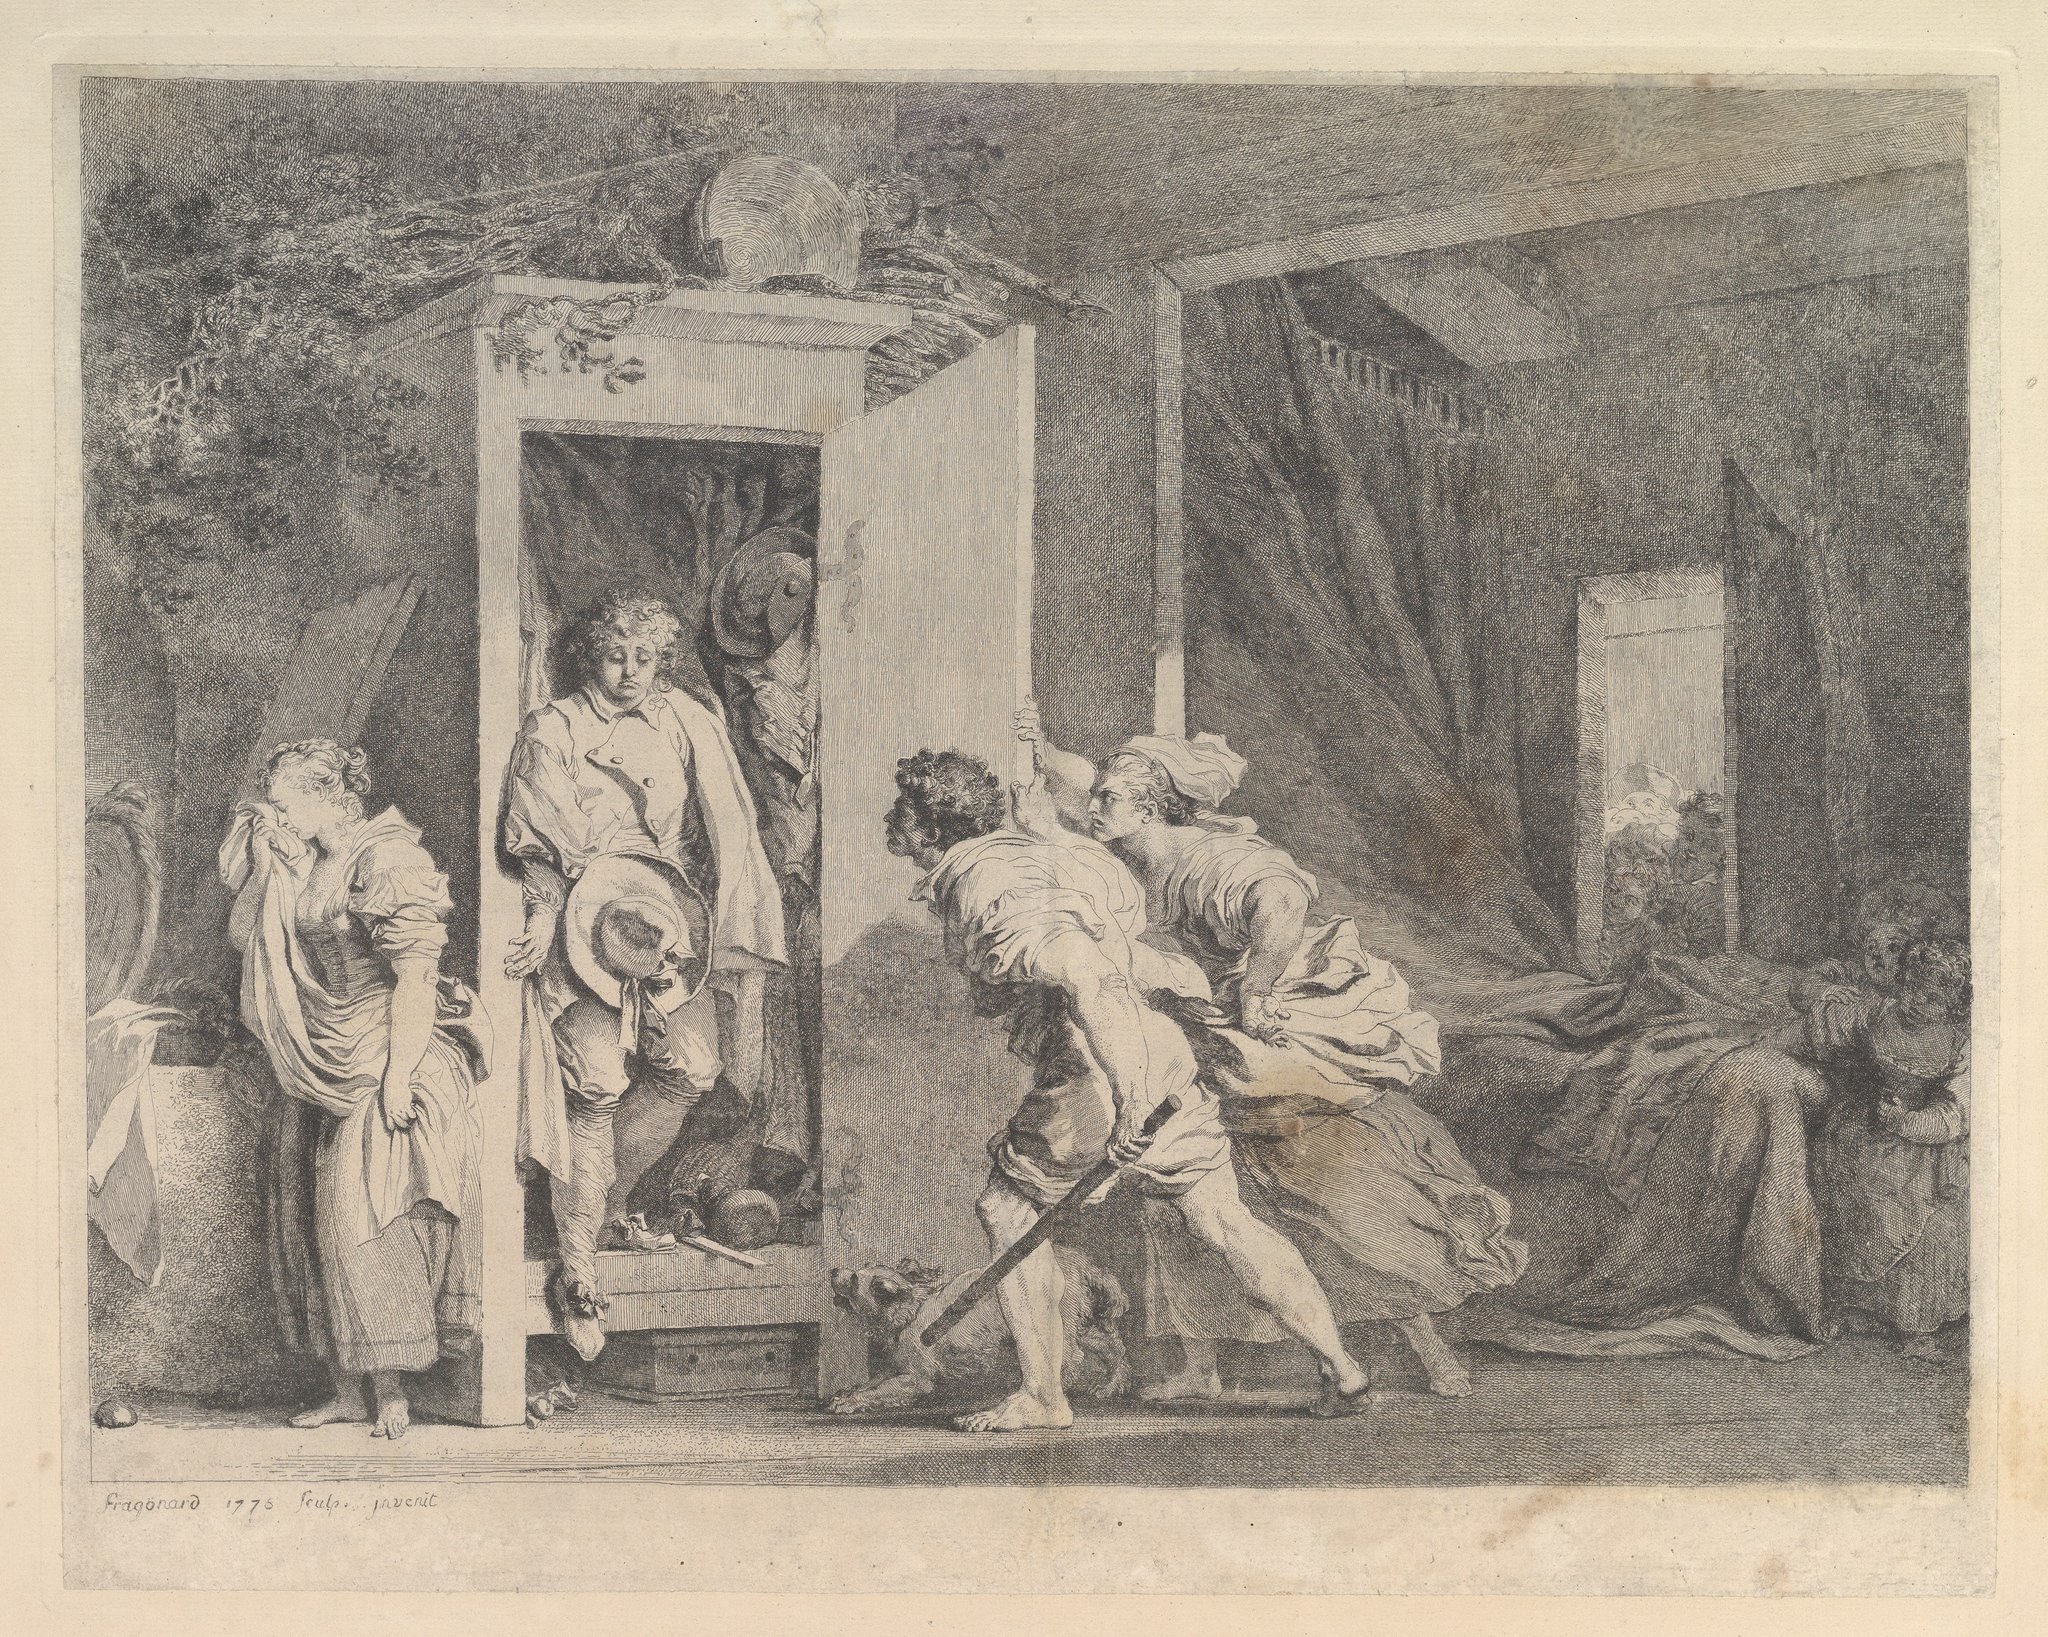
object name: print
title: L'Armoire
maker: jean honoré fragonard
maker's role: artist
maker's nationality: french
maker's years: 1732-1806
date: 1778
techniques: etching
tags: interiors,men,women